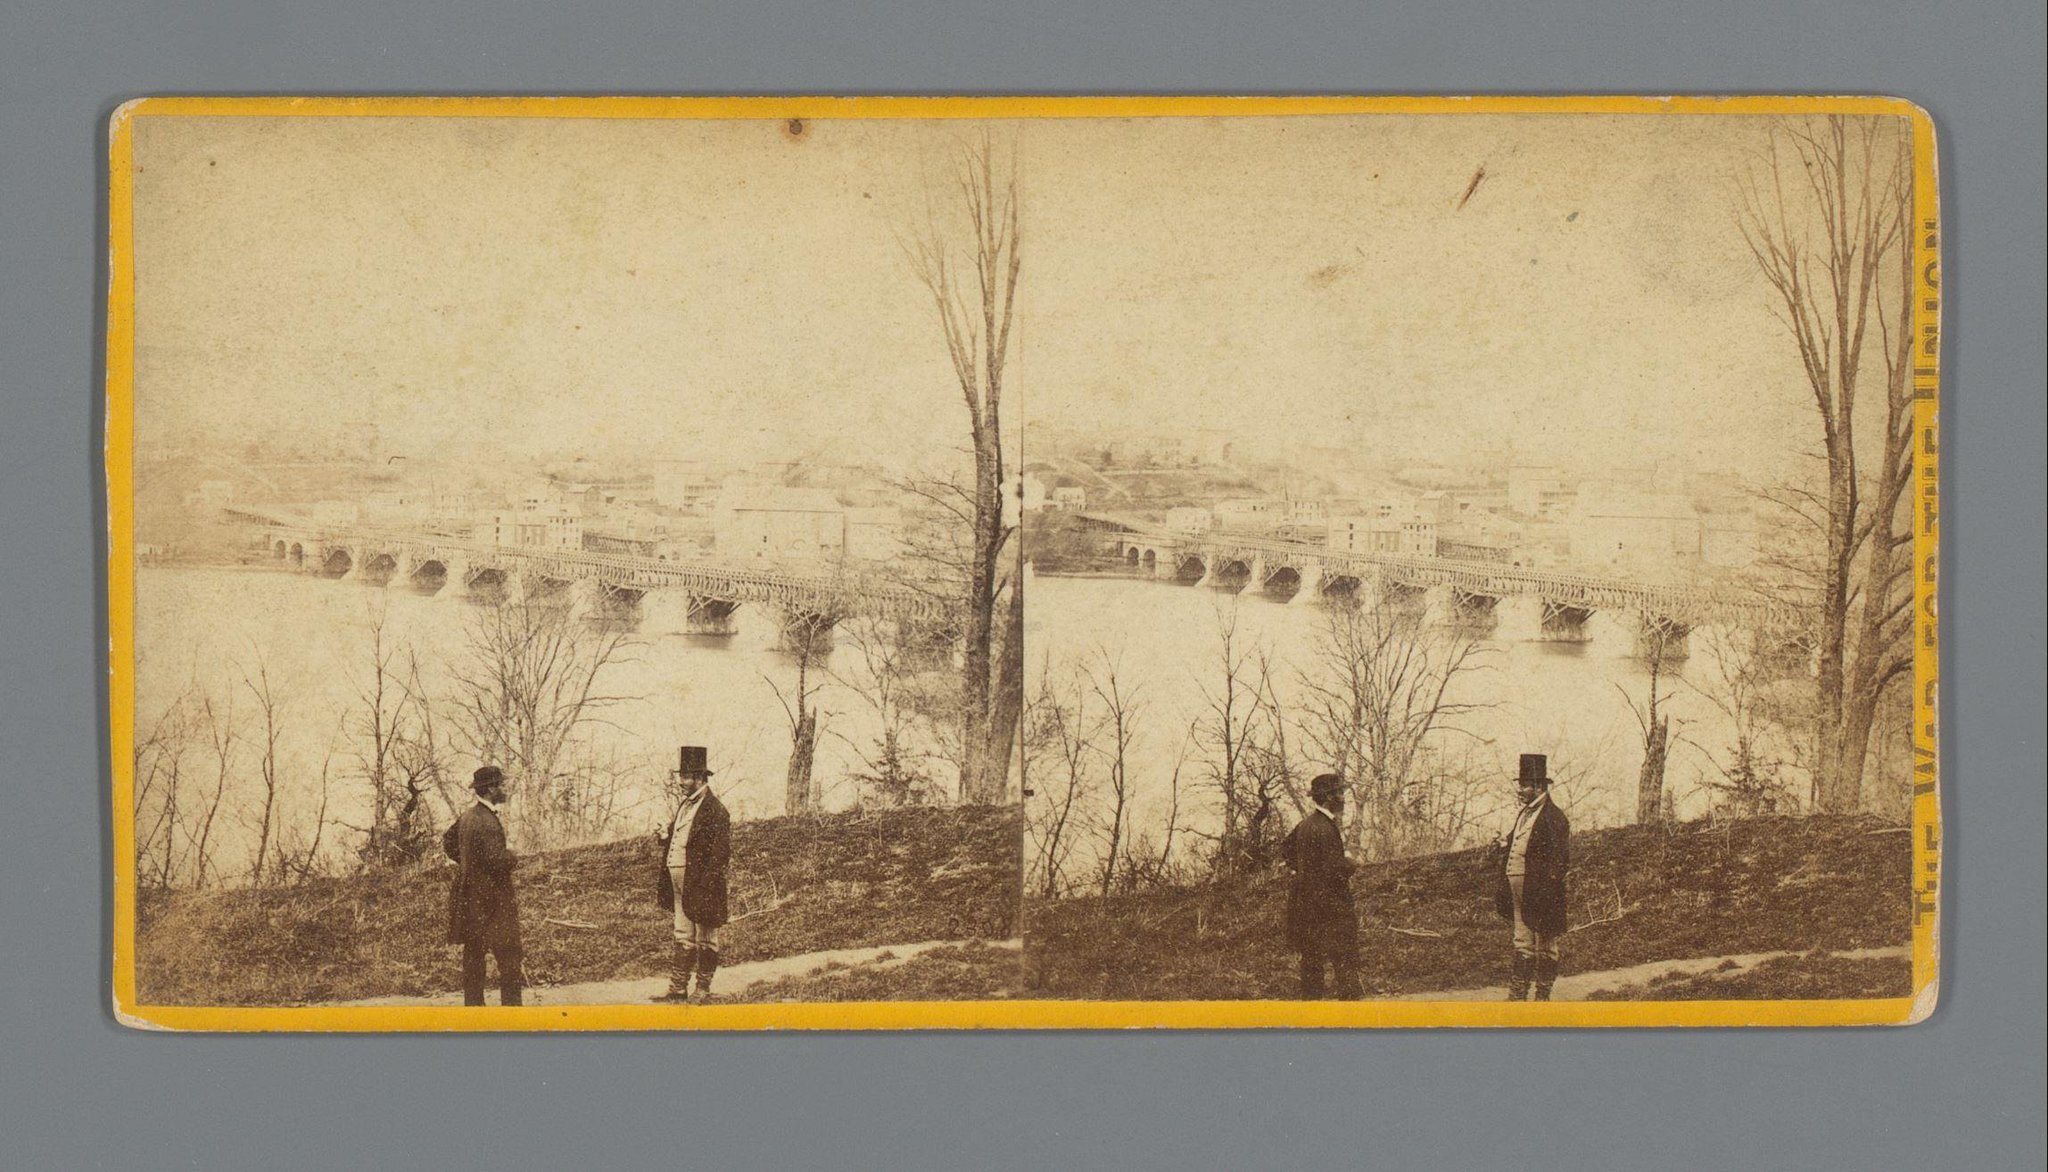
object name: stereograph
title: Aqueduct Bridge, from Fort Corcoran, Va.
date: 1861-1865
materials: cardboard, paper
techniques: albumen print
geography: virginia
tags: fortress, landscape with bridge, viaduct or aqueduct, lake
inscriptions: number: ‘#166’, address: ‘AMERICAN AND FOREIGN STEREOSCOPIC EMPORIUM, 501 BROADWAY, NEW-YORK.’, inscription: ‘z’, inscription: ‘8-’, number: ‘No. 2308.’, inscription: ‘Negative by BRADY & Co., Washington.’